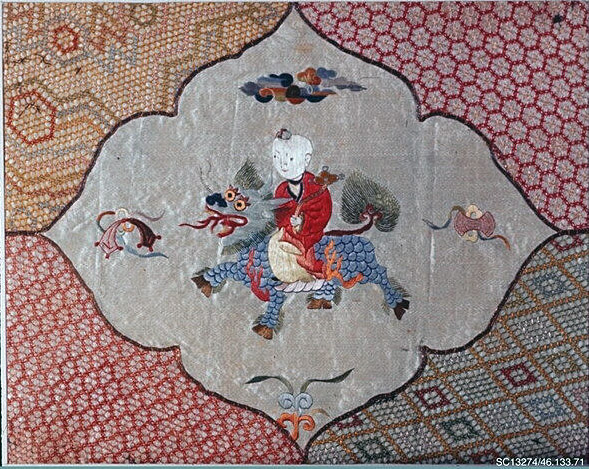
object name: piece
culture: chinese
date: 1767-1833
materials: metal thread, silk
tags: animals